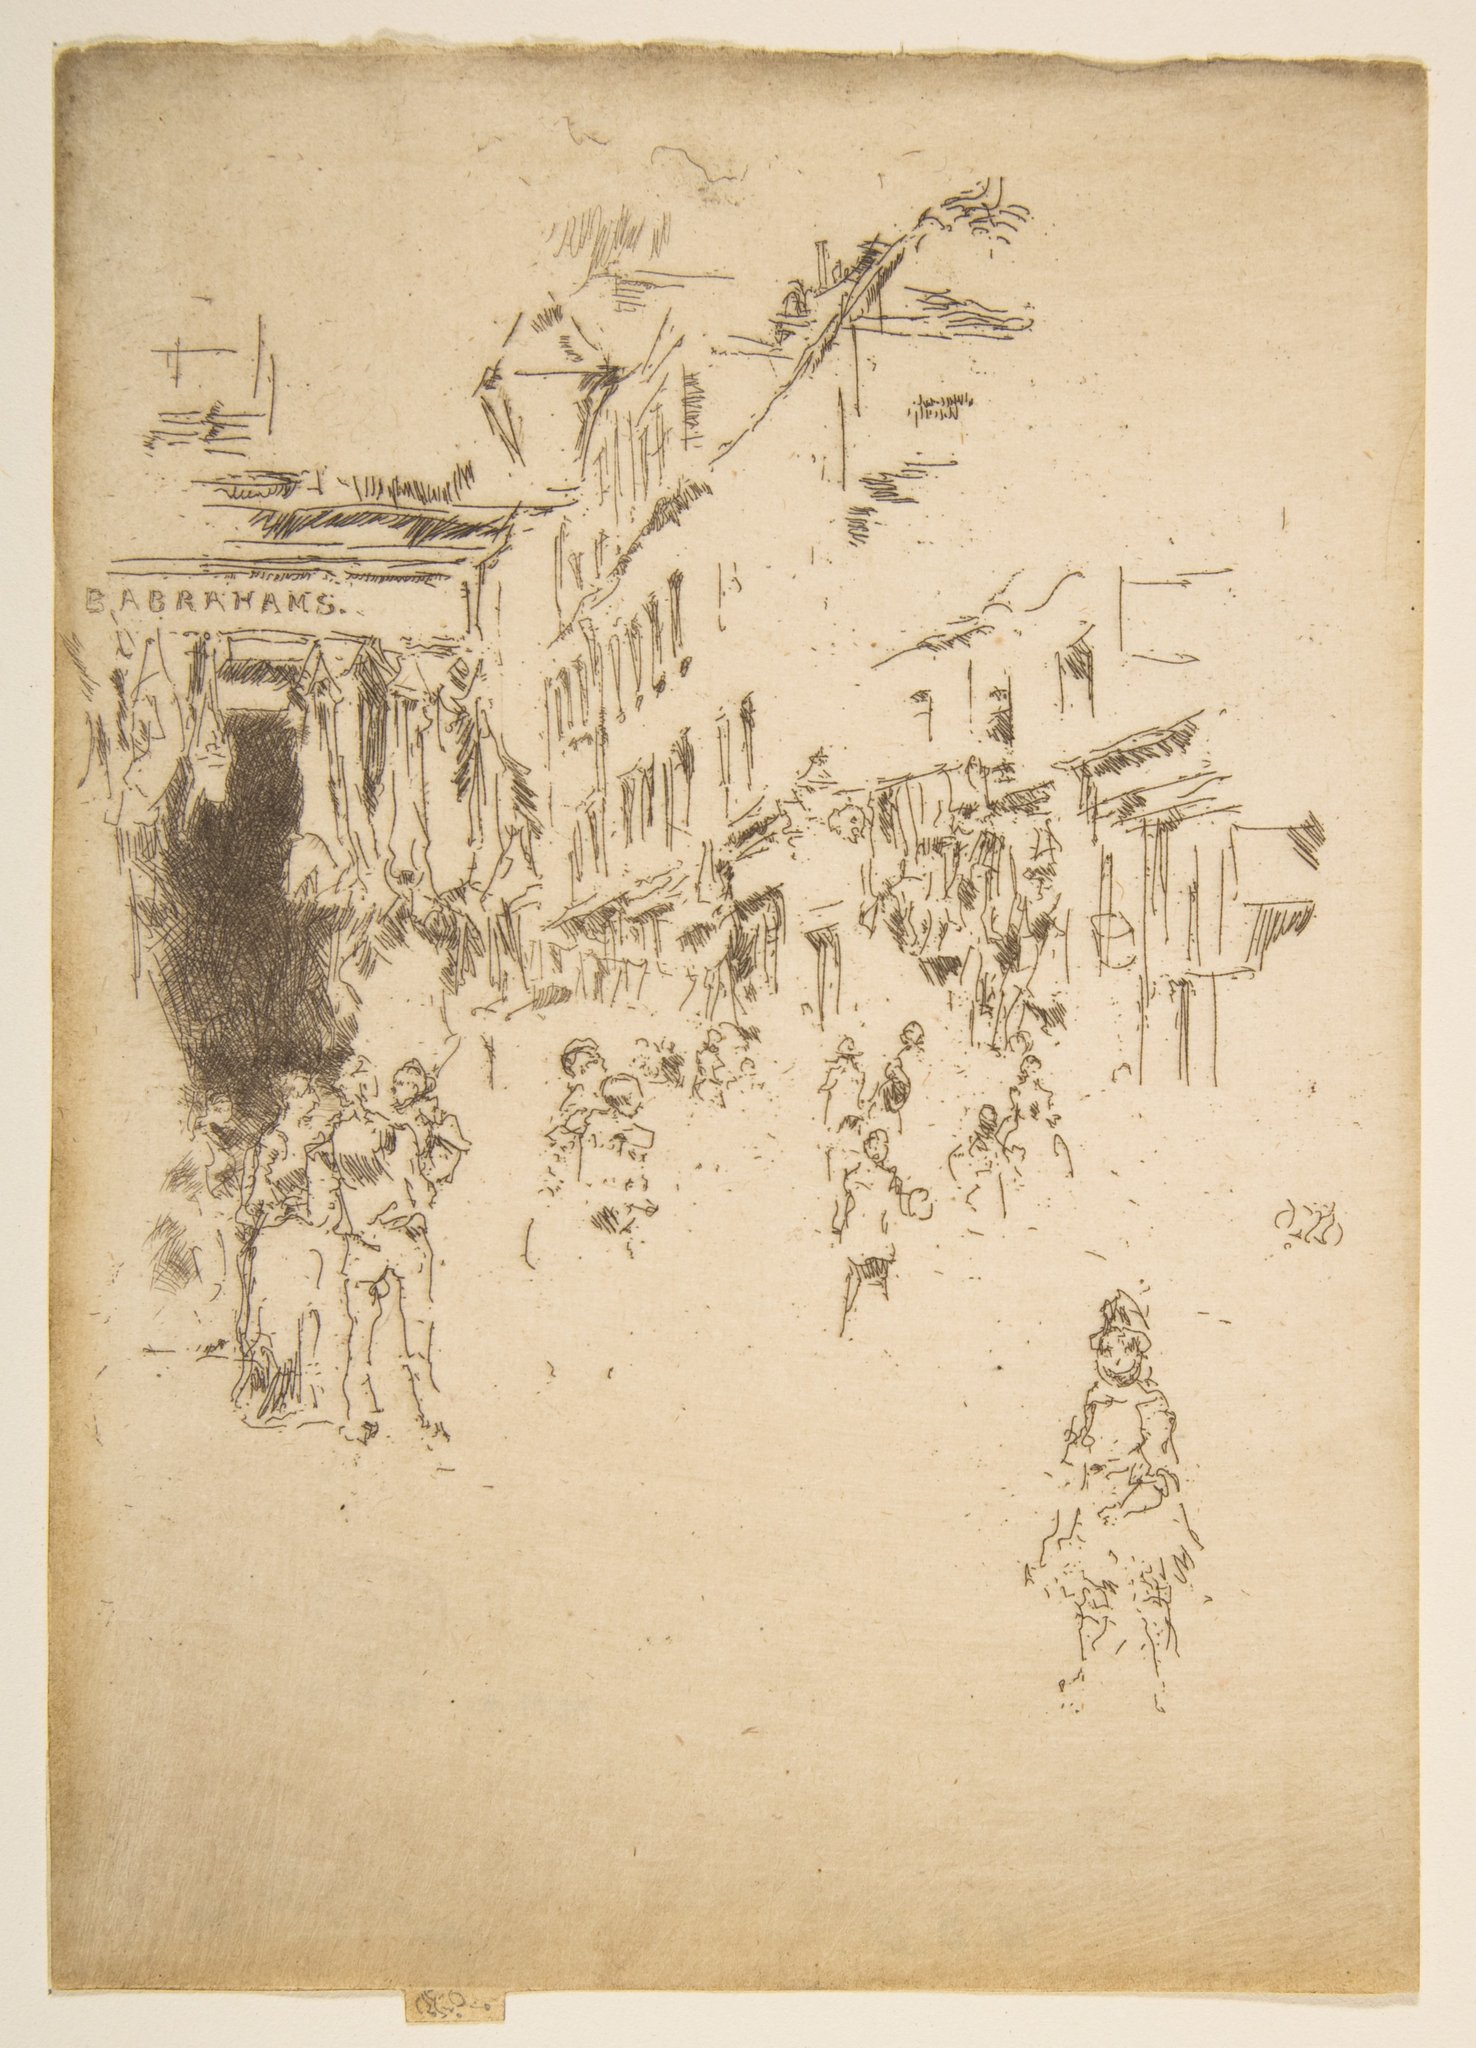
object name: print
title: Cutler Street, Houndsditch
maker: james mcneill whistler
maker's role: artist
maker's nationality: american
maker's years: 1834-1903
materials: ink, paper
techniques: etching, printing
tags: human figures,buildings,streets